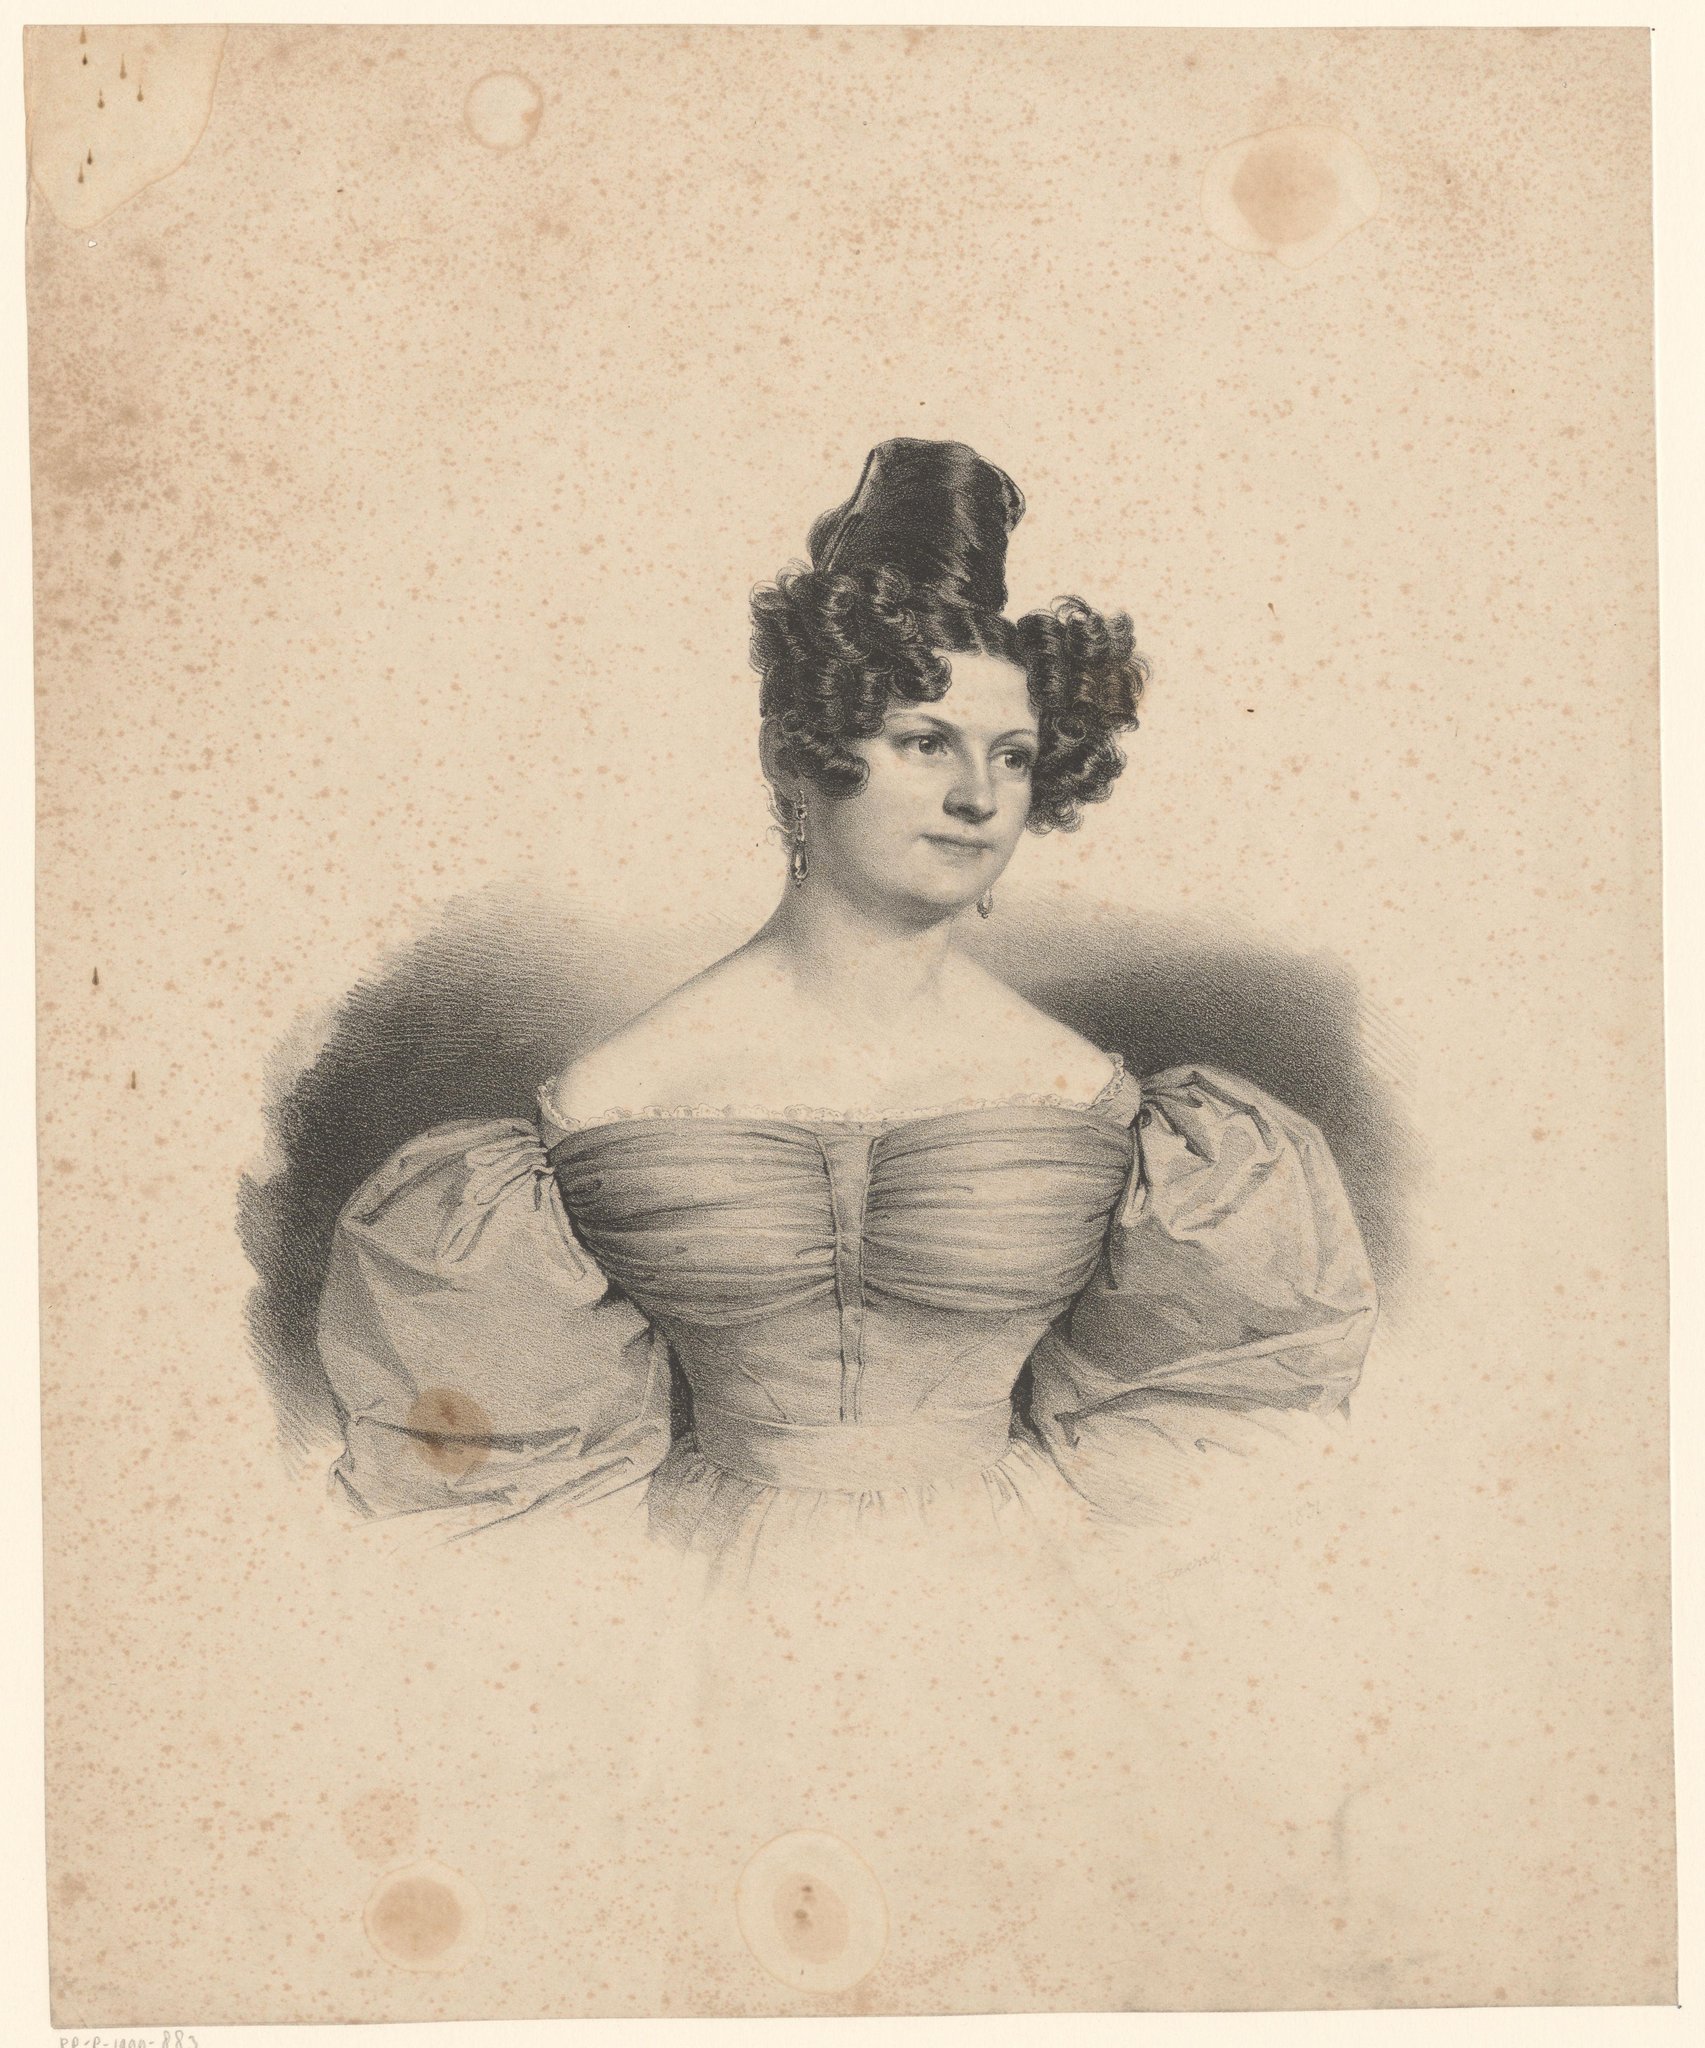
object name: print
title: Portret van een onbekende vrouw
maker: franz seraph hanfstaengl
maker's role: painter, print maker, printer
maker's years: 1804-1877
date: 1831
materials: paper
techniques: lithograph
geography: germany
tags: adult woman, historical persons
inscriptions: collector's mark: Lugt 2760, collector's mark: Lugt 2228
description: Portret van een onbekende vrouw, ten halve lijve, naar rechts, in japon met decolleté. Knotje op het hoofd.